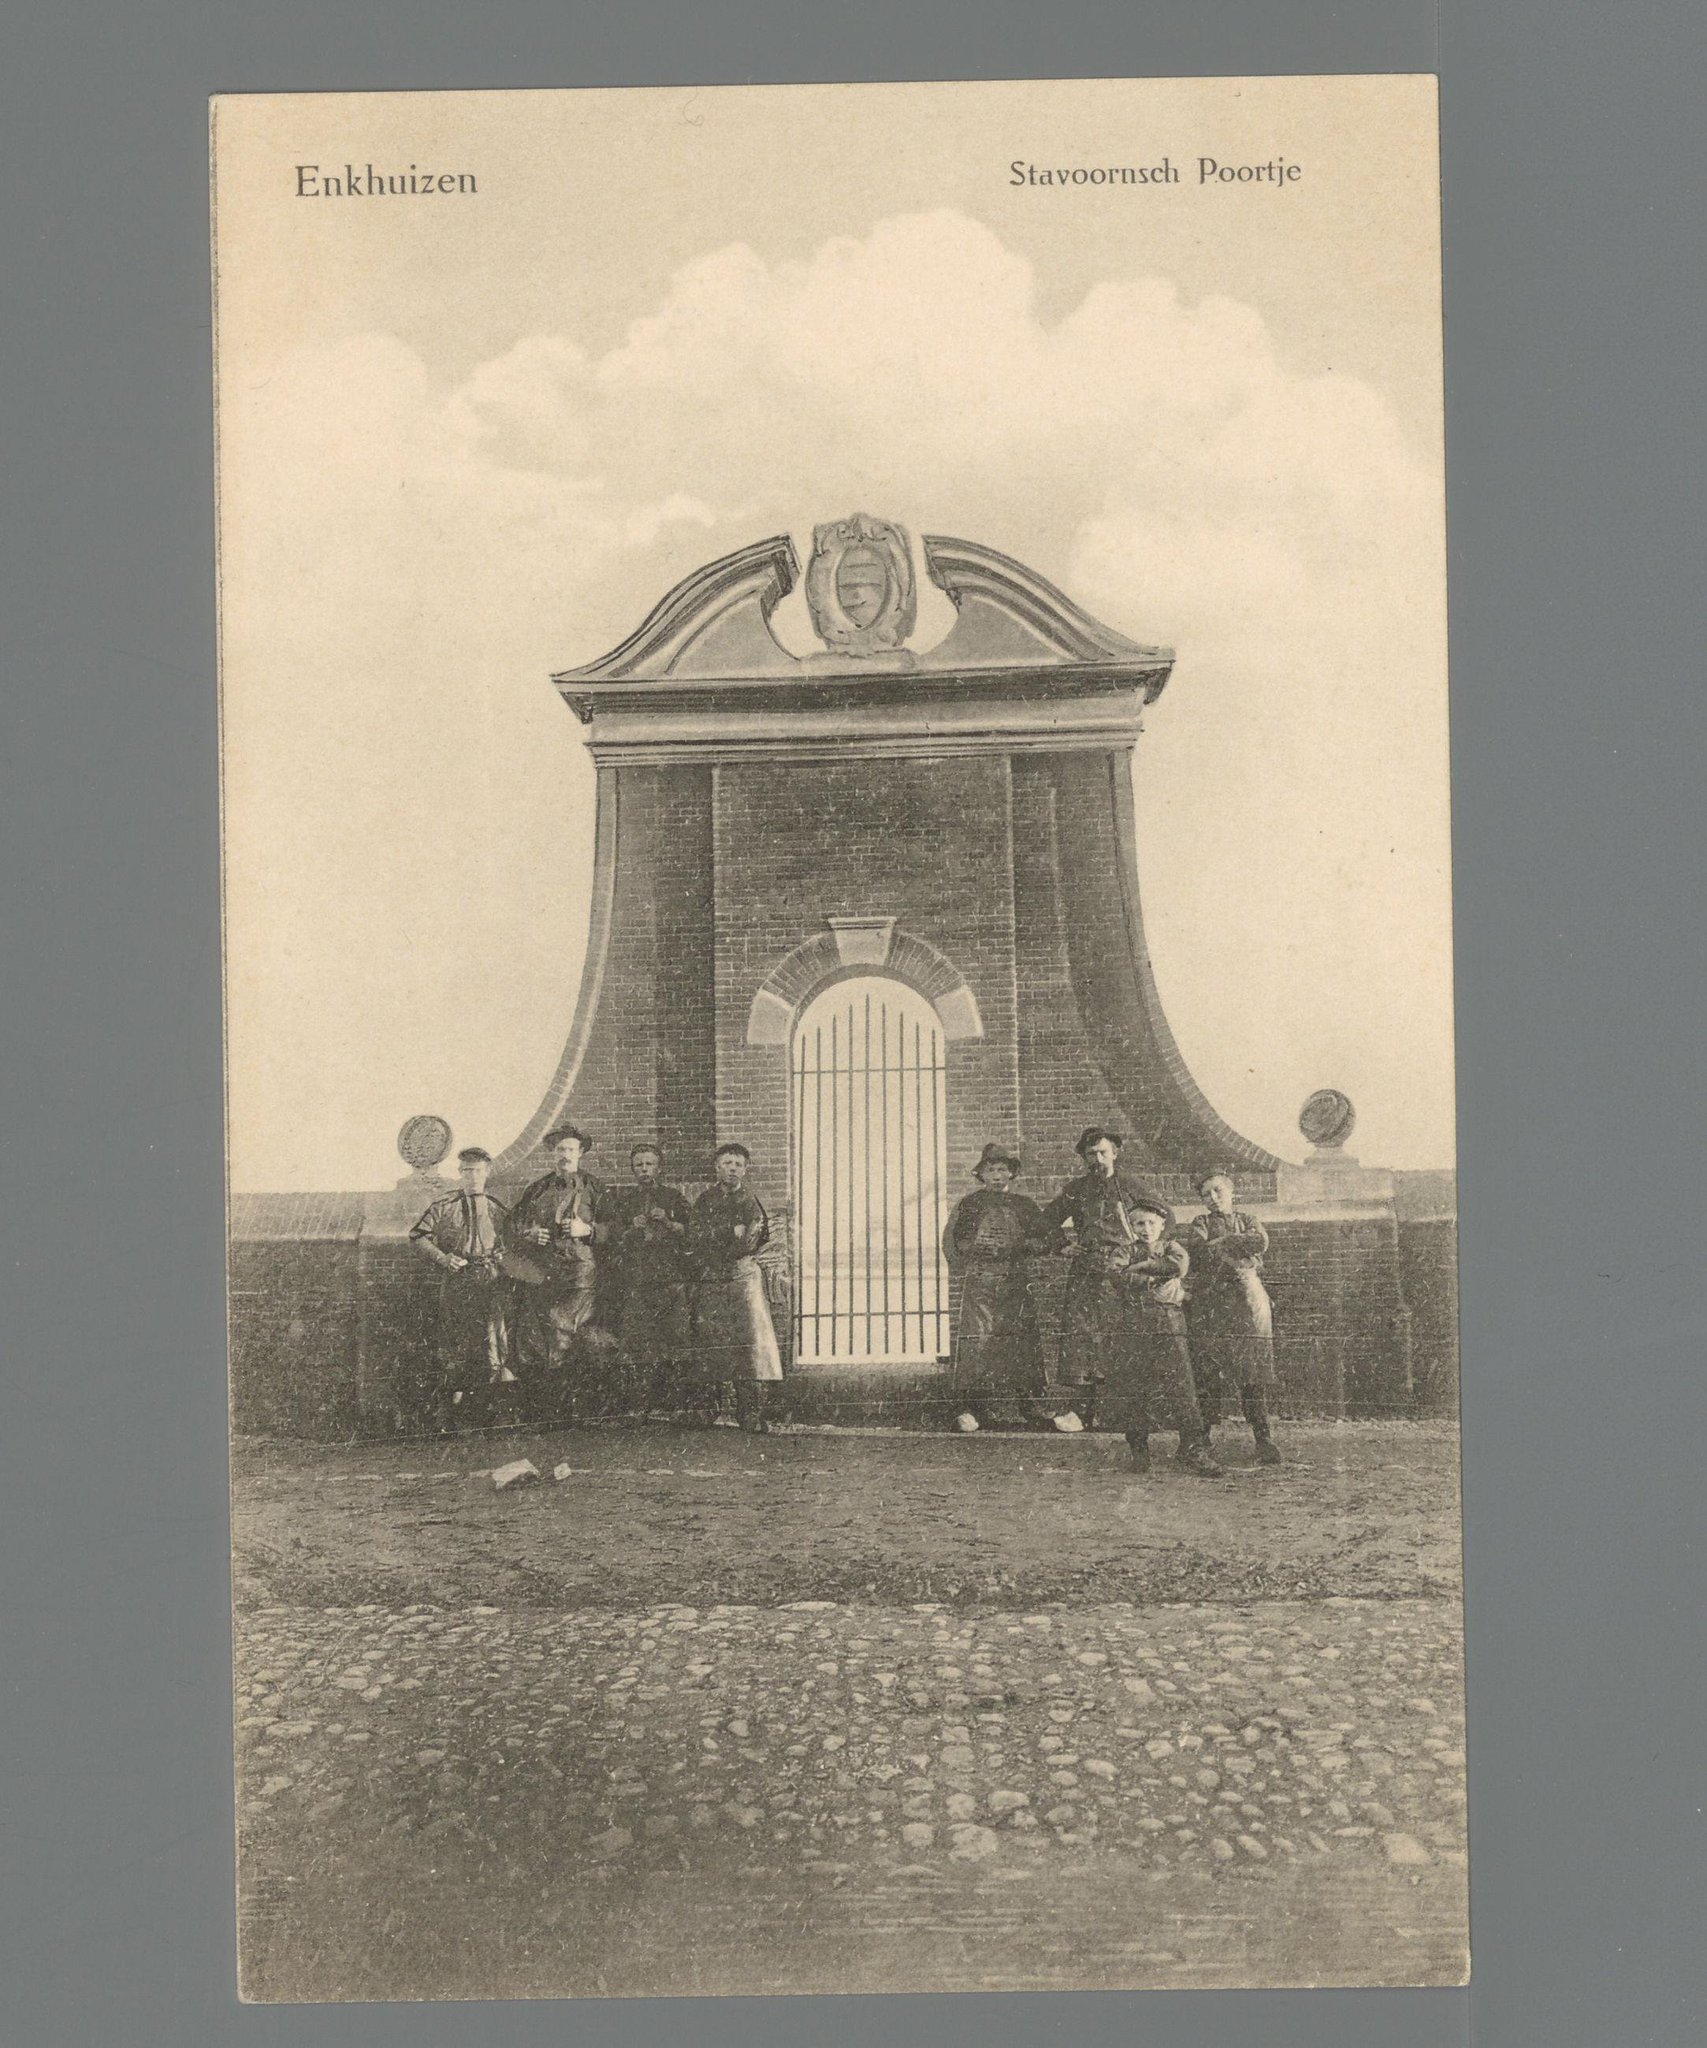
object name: photomechanical print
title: Enkhuizen. Stavoornsch Poortje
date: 1909-1912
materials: cardboard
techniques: photograph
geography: enkhuizen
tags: city-gate, clothes, costume, enkhuizen